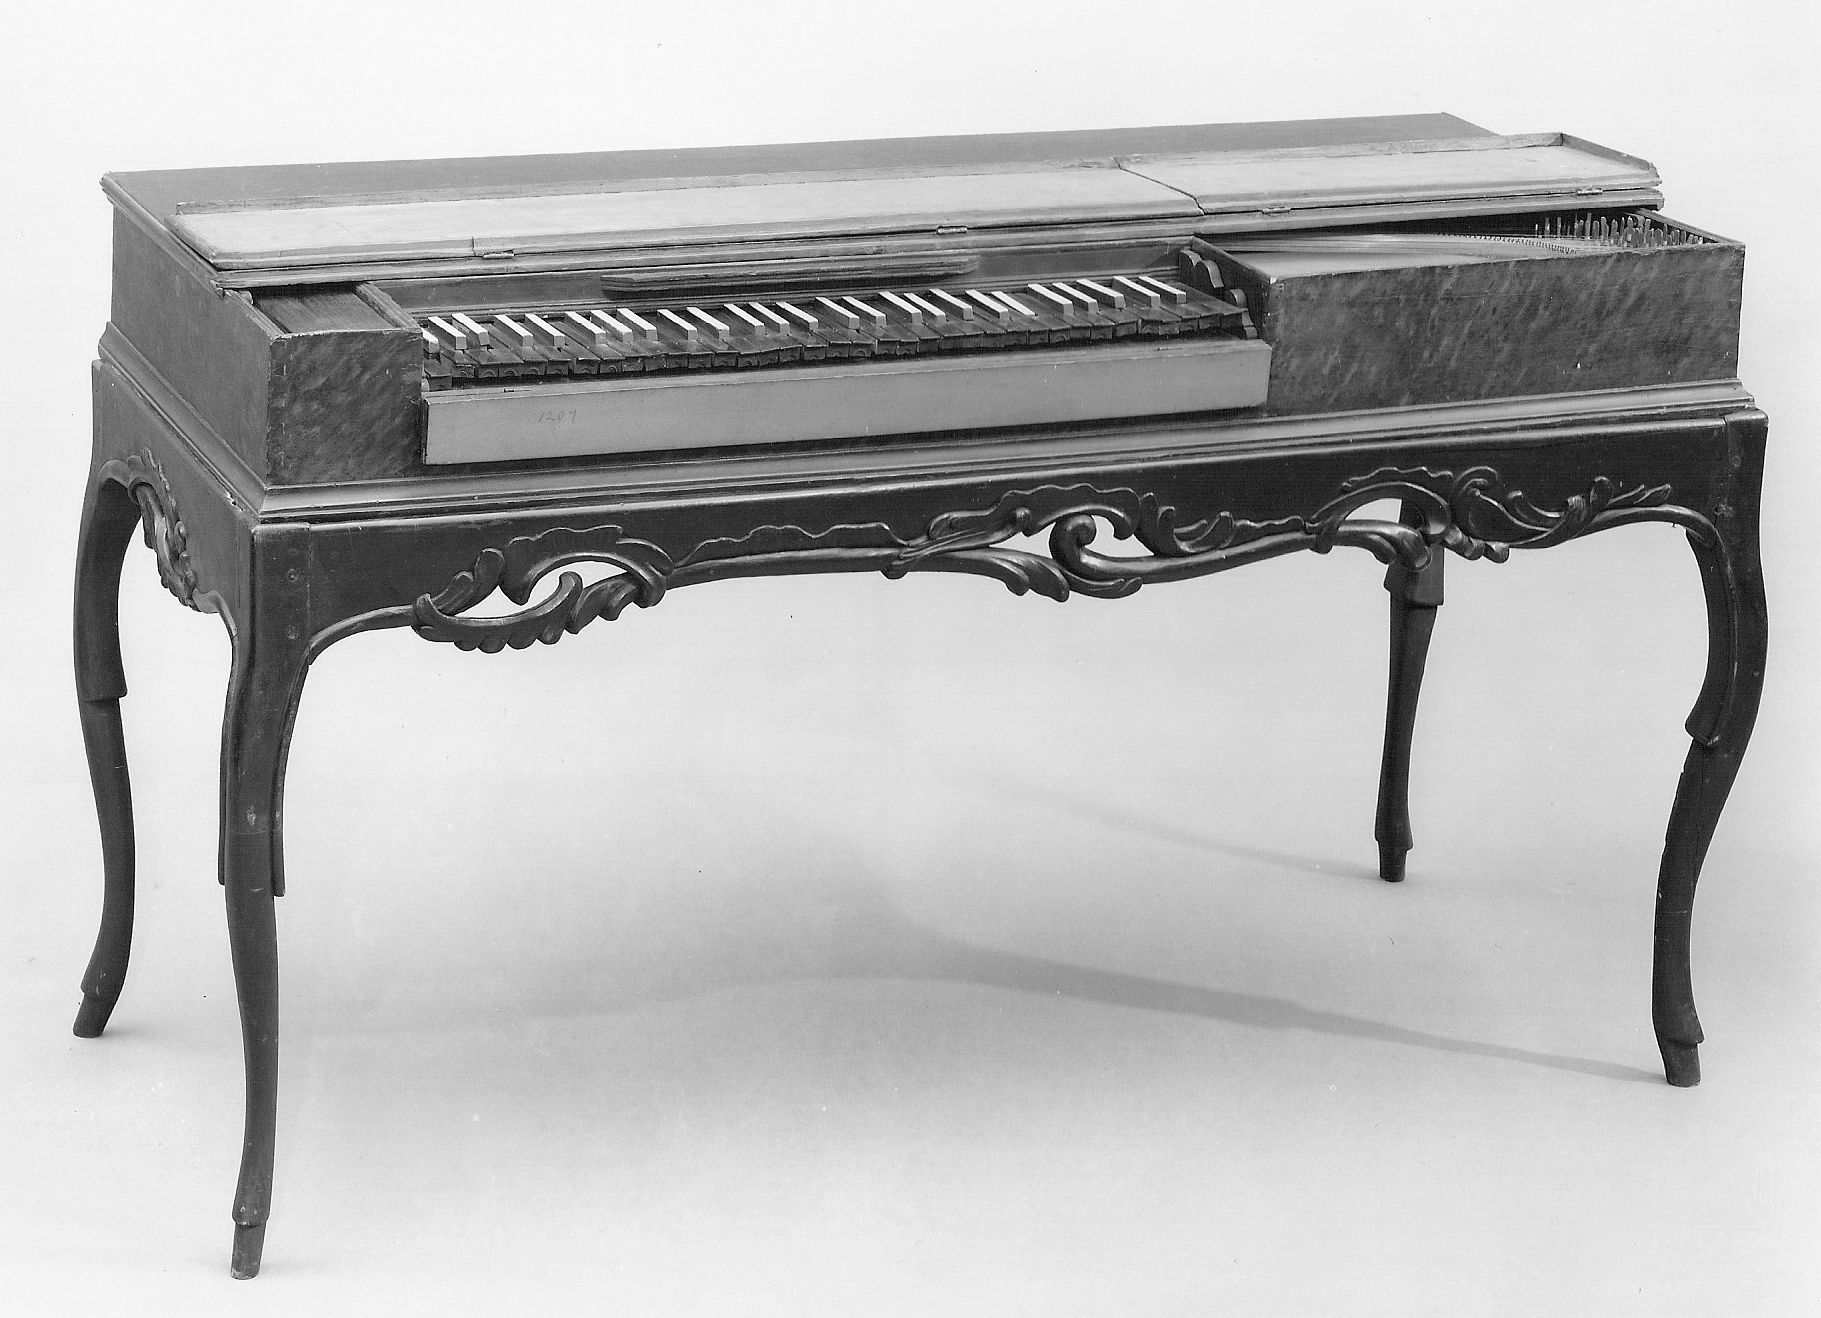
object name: clavichord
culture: german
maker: johann christoph jesse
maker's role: maker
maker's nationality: german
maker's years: 1705-1787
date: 1765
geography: germany